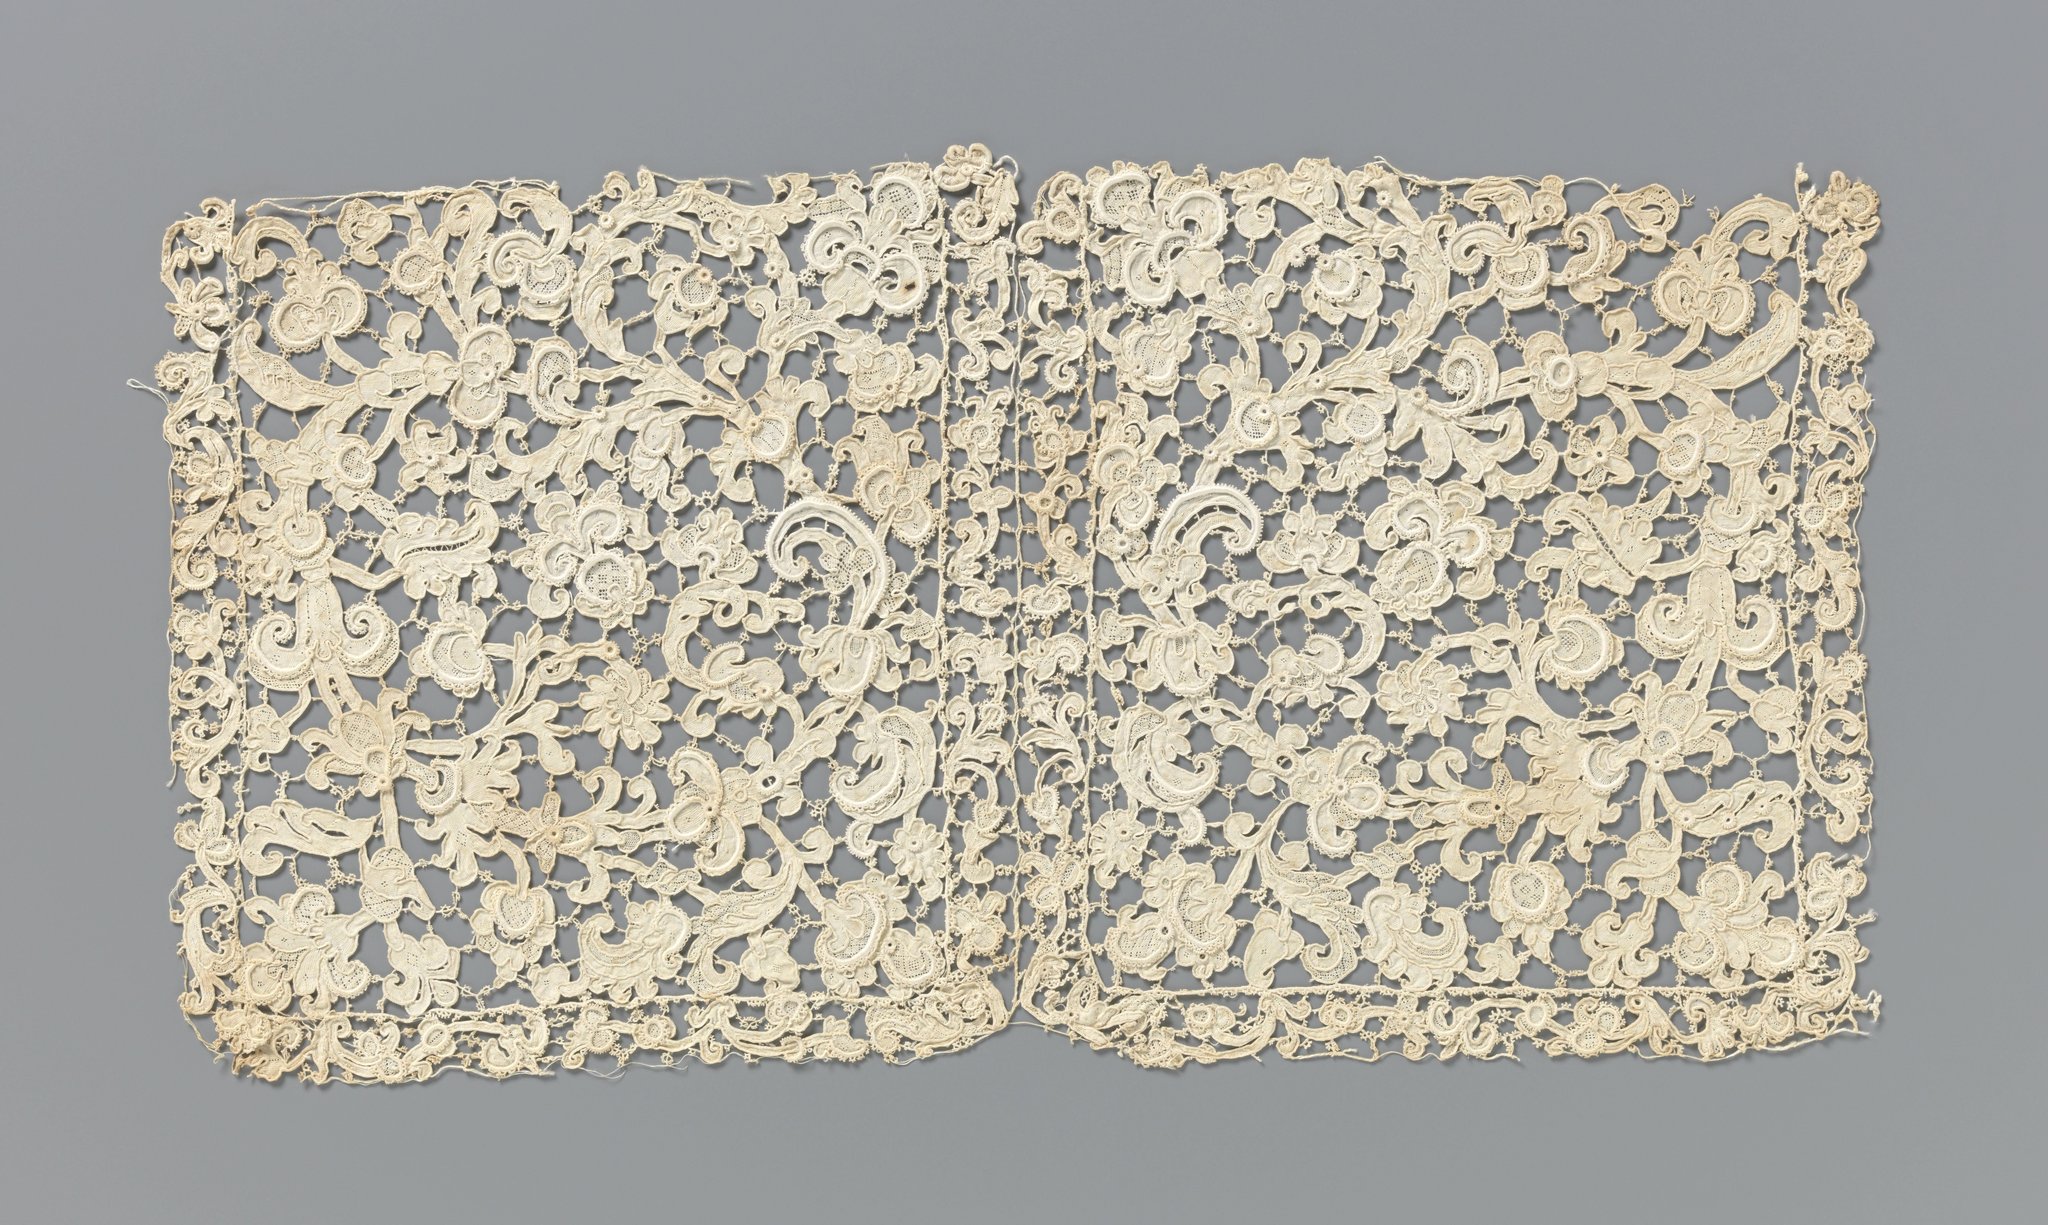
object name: jabot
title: Jabot van naaldkant bestaande uit twee aan elkaar genaaide slippen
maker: Anonymous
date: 1700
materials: linen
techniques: embroidery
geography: europe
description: Jabot van naturelkleurige naaldkant: Venetiaanse reliëfkant. Het patroon bestaat uit omkrullende ranken met bladeren en bloemen. De motieven zijn gemaakt met festonsteken met uitsparingen en ze zijn voorzien van reliëfcontouren. Extra reliëf is gemaakt met cordons. Drie zijden van elke slip zijn voorzien van een smalle rand met fijner lofwerk. De motieven zijn met elkaar verbonden door een grond van spijlen met (rader)picots.